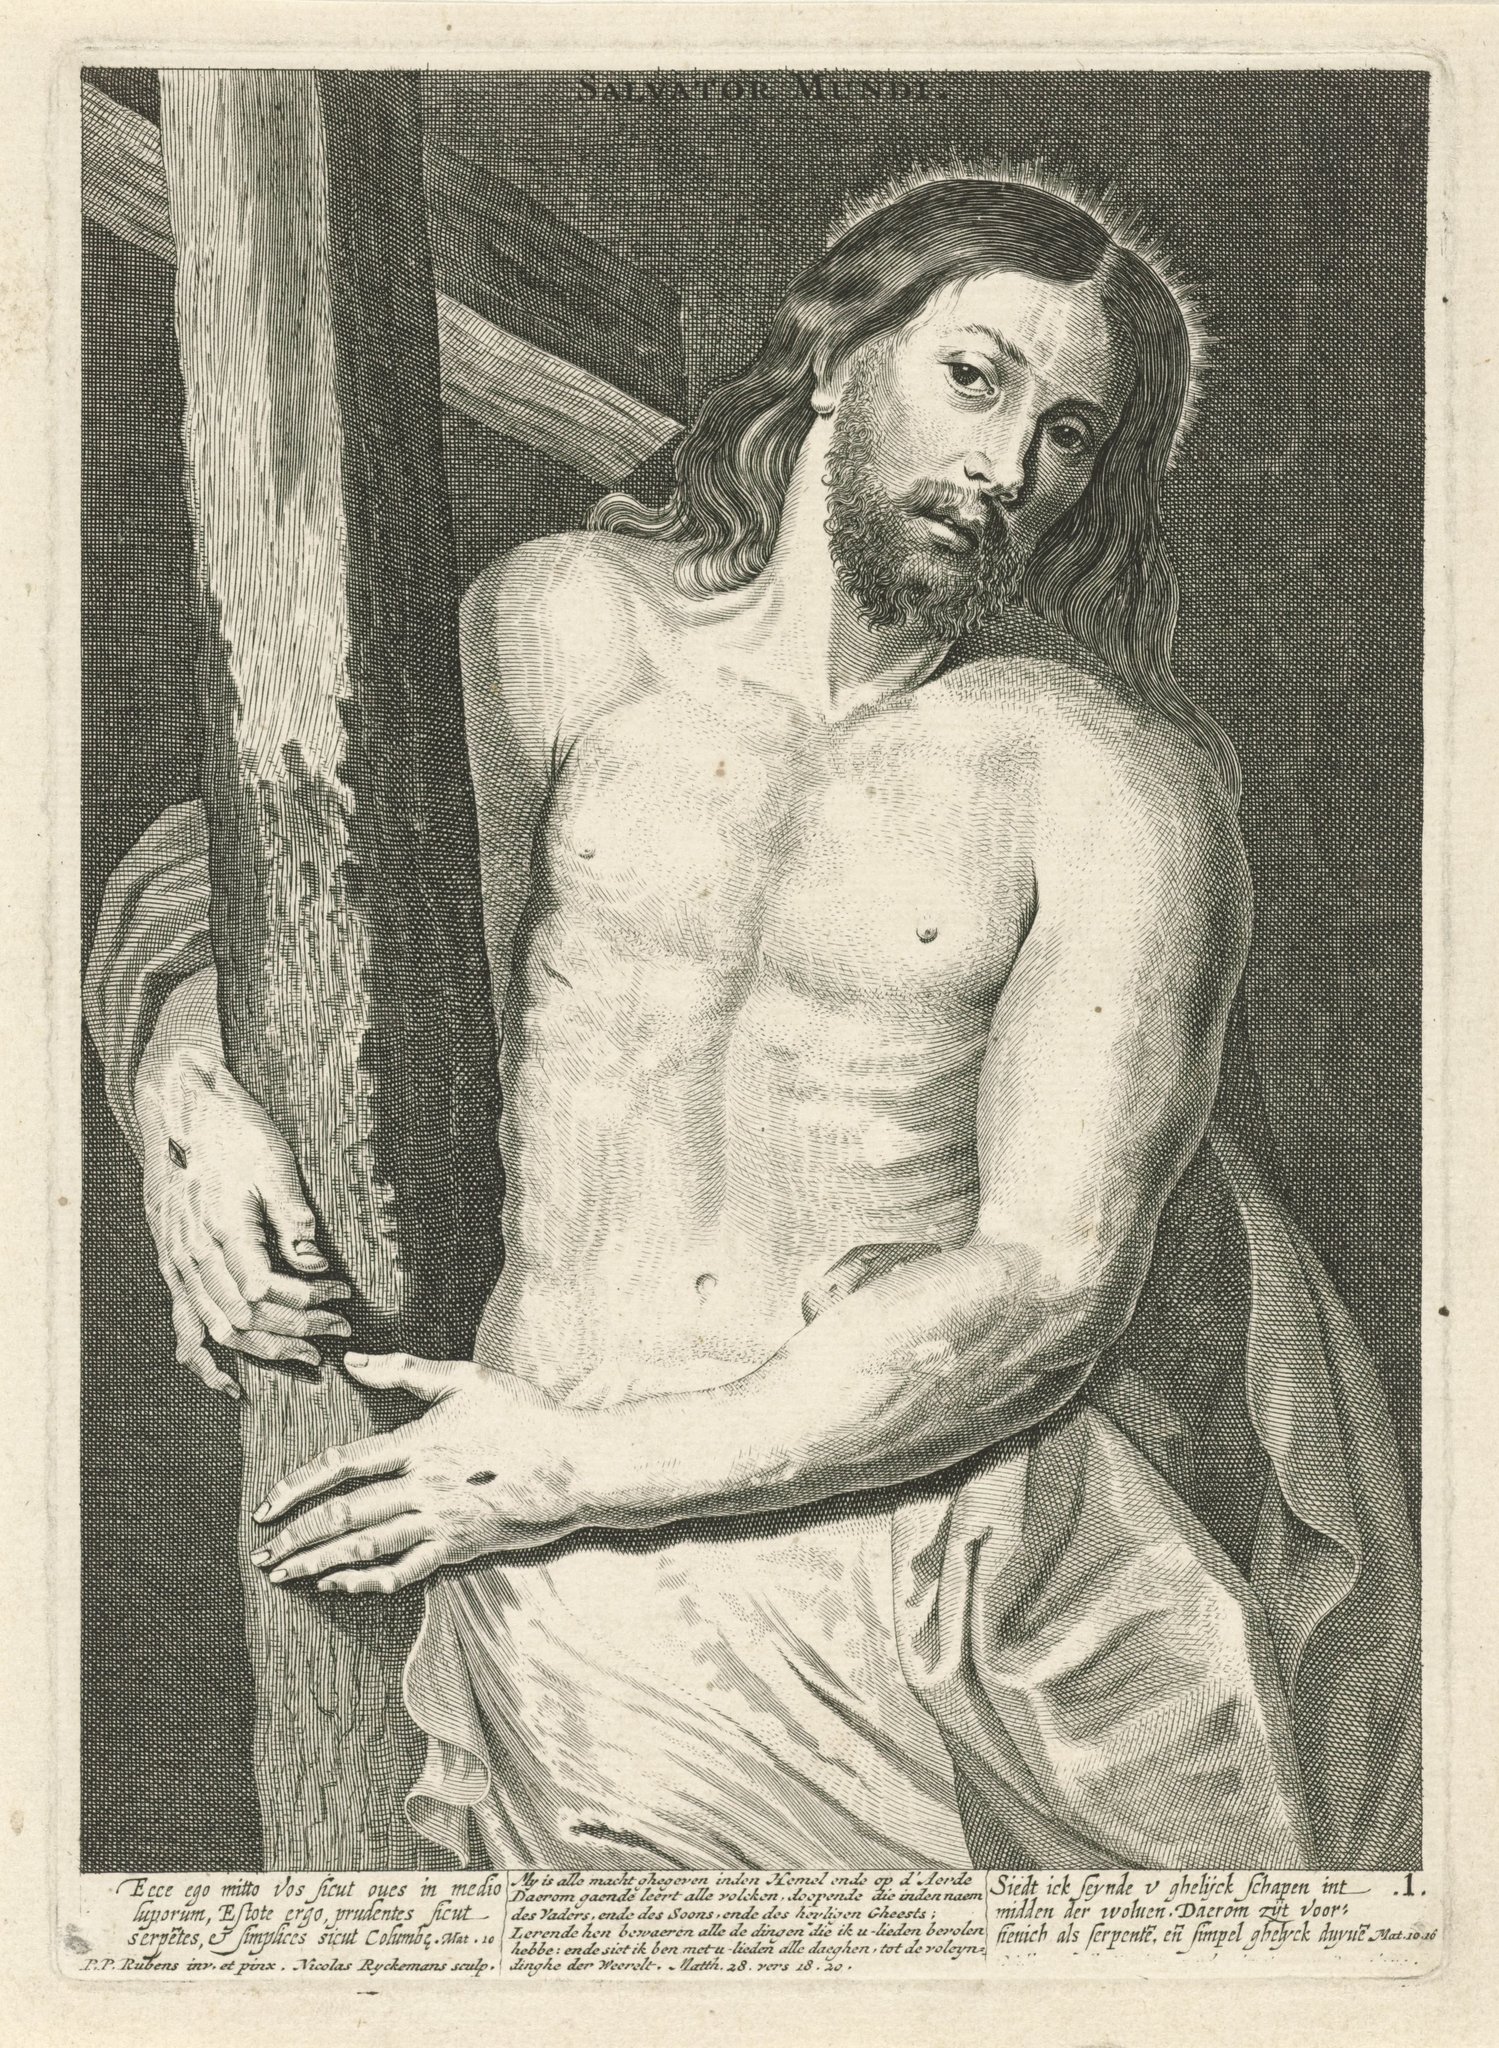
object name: print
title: Christus met het kruis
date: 1605-1675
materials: paper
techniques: engraving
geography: northern netherlands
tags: christ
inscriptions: collector's mark: Lugt 2228